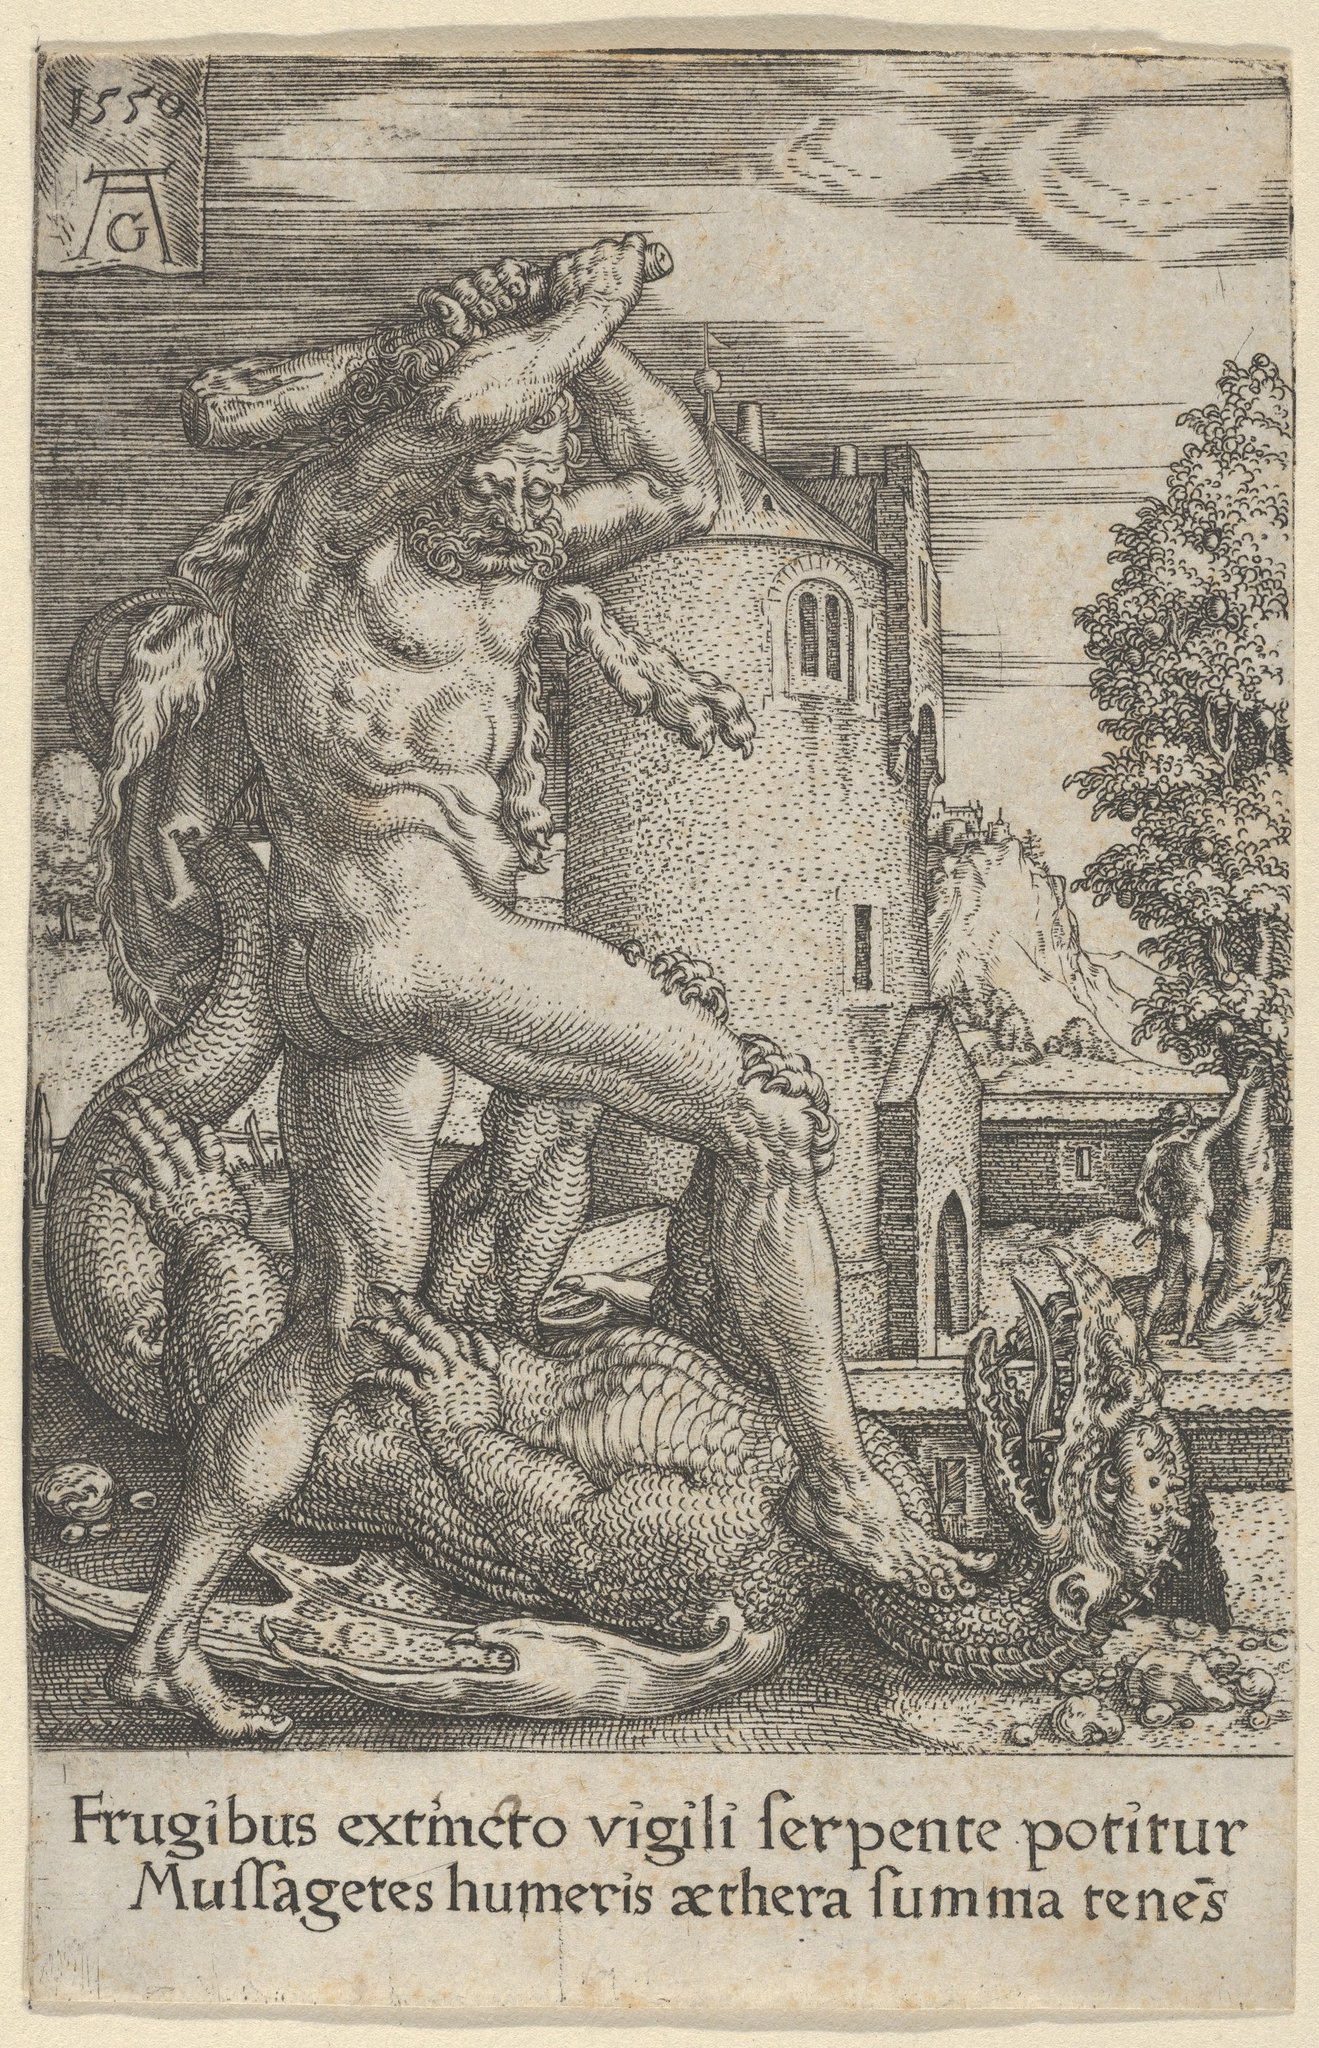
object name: print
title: Hercules Killing the Dragon Ladon, from "The Labors of Hercules"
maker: heinrich aldegrever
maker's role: artist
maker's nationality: german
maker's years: 1502-1561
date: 1550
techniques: engraving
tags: hercules,dragons